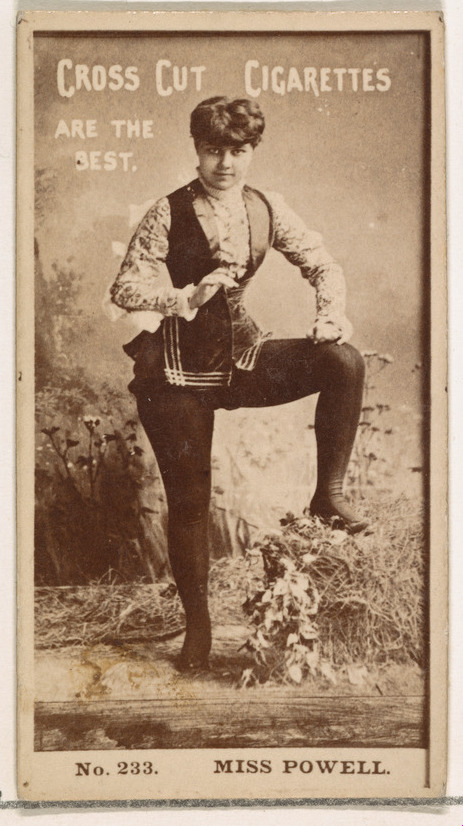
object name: print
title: Card Number 233, Miss Powell, from the Actors and Actresses series (N145-2) issued by Duke Sons & Co. to promote Cross Cut Cigarettes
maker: w. duke, sons & co.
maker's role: publisher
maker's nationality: american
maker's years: 1870-1920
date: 1880-1889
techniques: albumen silver print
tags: portraits,women,actresses